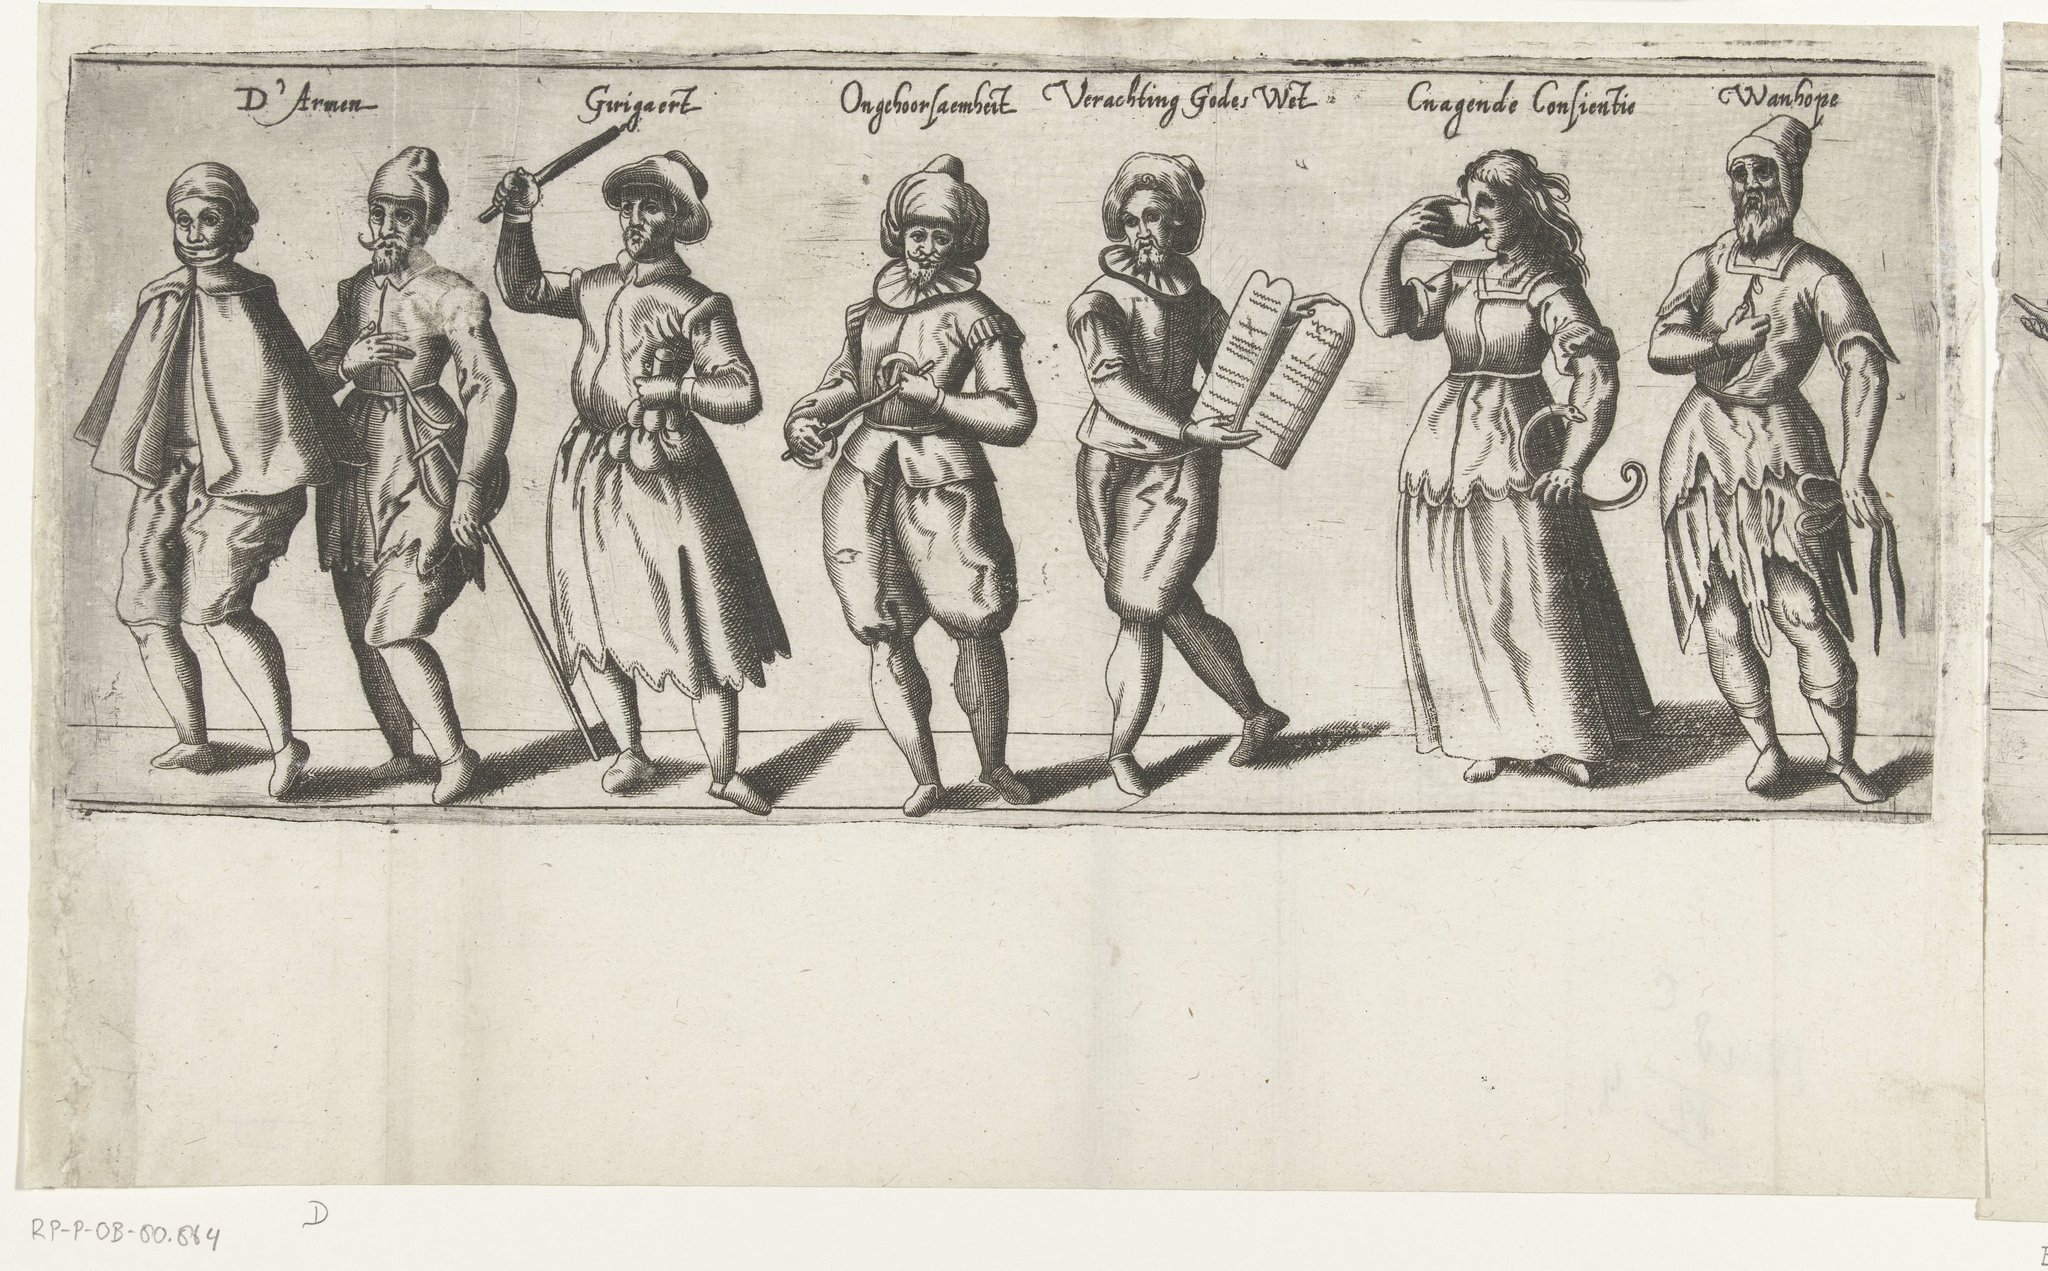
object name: print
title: Optocht door de rederijkerskamer Den Aeckerboom uit Vlaardingen (vierde deel), 1607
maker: Anonymous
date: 1607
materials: paper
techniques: engraving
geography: northern netherlands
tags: chamber of rhetoric (dutch: 'rederijkerskamer'), festivities (+ parade, pageant, cavalcade ~ festive activities), works of mercilessness, haarlem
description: Gebruikt als illustratie in: Const-thoonende ivweel, by de loflijcke stadt Haerlem, ten versoecke van Trou moet blijcken, in't licht gebracht. : Waer inne duydelick verclaert ende verthoont wordt alles wat den mensche mach wecken om den armen te troosten, ende zijnen naesten by te staen. : In twaelf spelen van sinne ... in redenrijck naar de volgende voorgegevene caerte van 't speel-korenken, Zacharias Heyns, Zwolle 1607. Los fragment, bedoeld om samen met de andere delen tot een fries gemonteerd te worden.